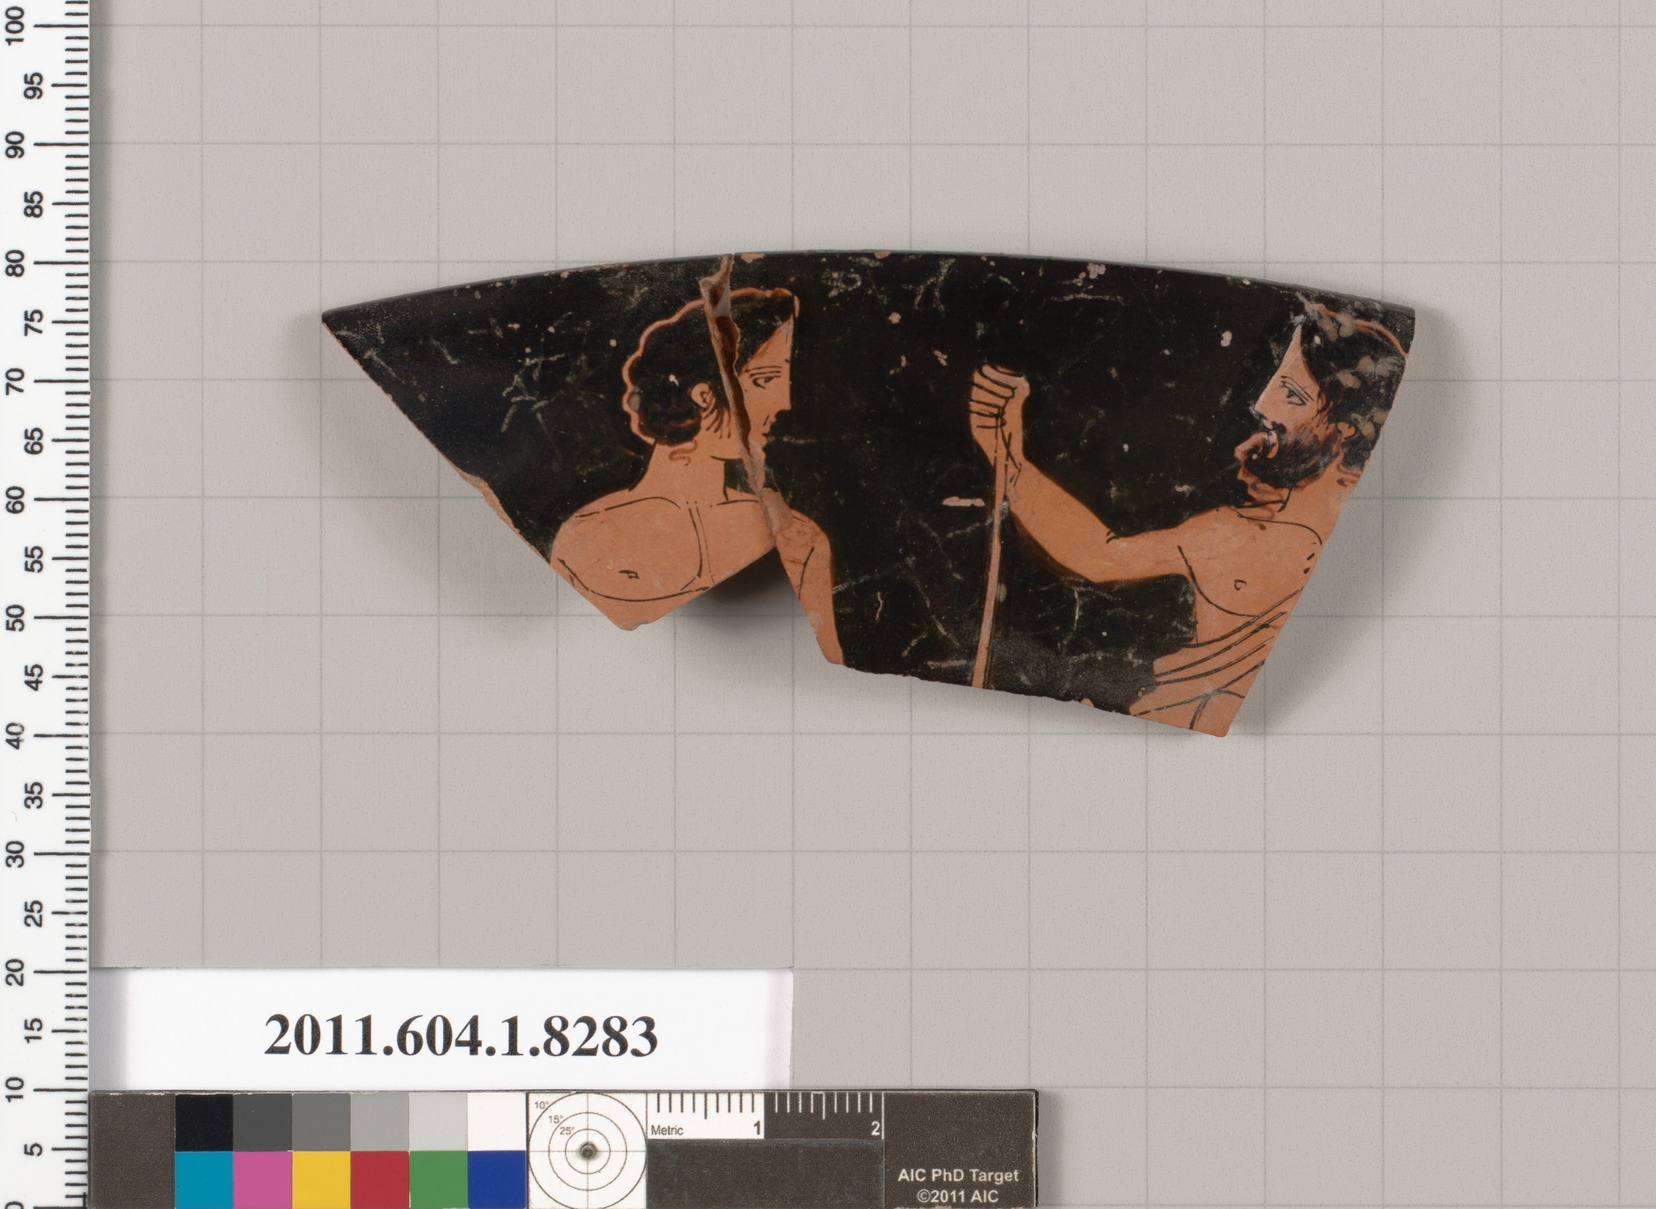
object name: kylix fragment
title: Terracotta rim fragment of a kylix (drinking cup)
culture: greek, attic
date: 425-401 BCE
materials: terracotta